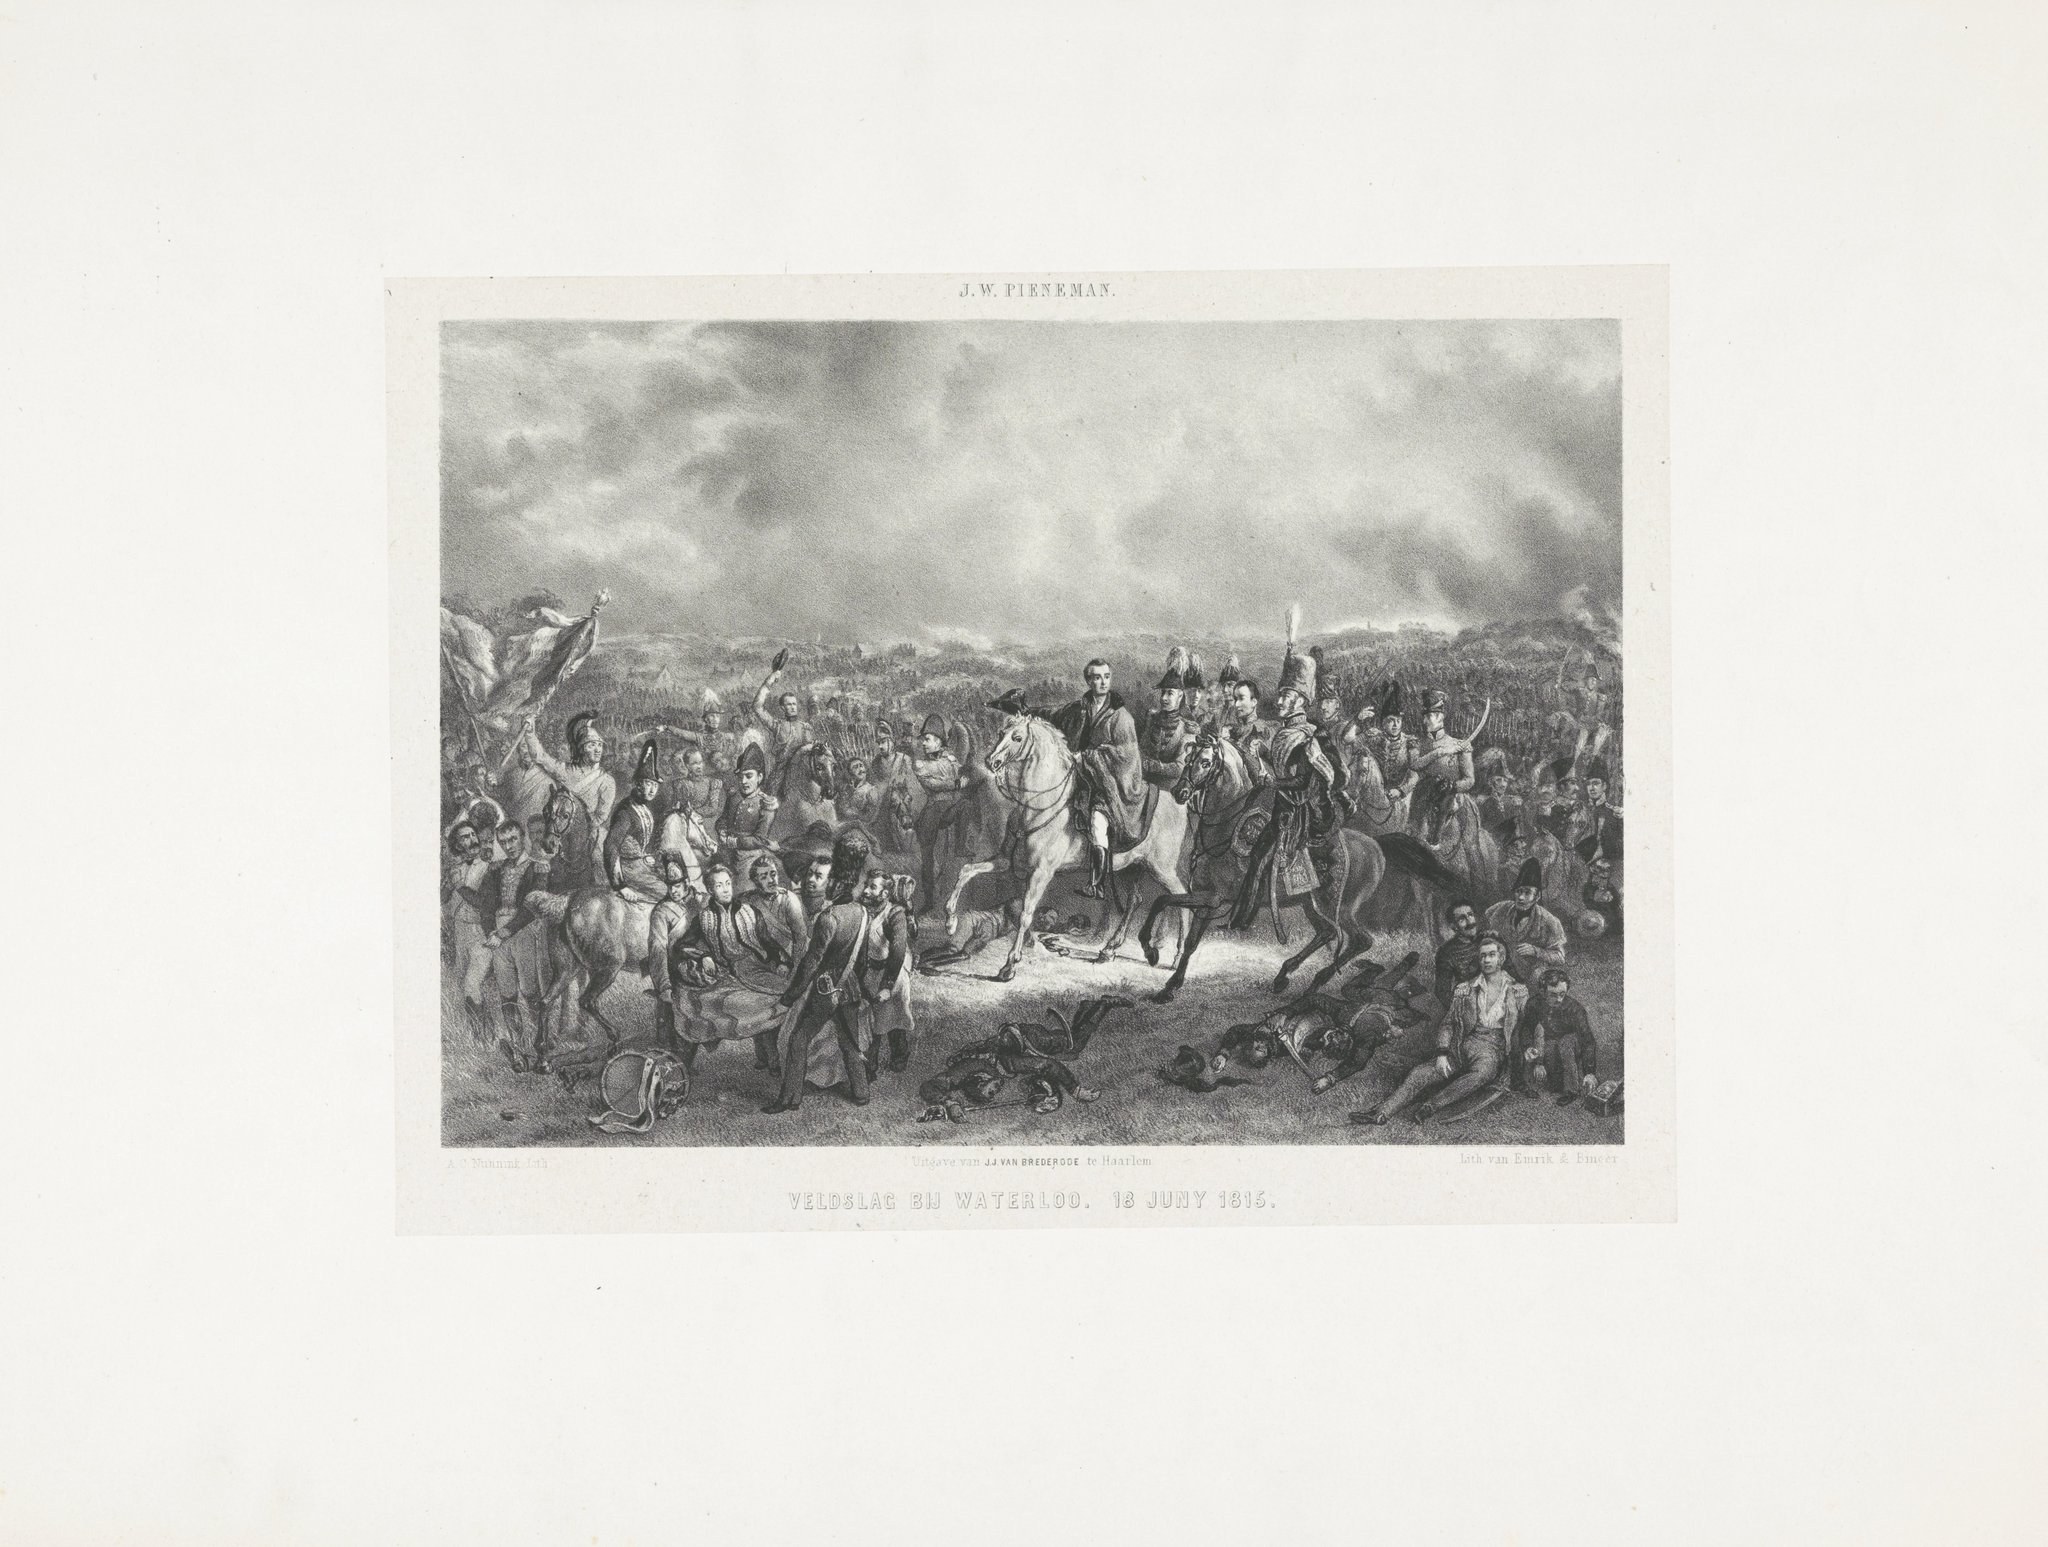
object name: history print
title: Veldslag bij Waterloo. 18 Juny 1815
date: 1824-1850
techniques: printmaking, lithograph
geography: haarlem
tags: the hague, william ii of the netherlands, walmer castle, arthur wellesley of wellington, battle (+ land forces), waterloo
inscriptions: collector's mark: Lugt 2166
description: De slag bij Waterloo, 18 juni 1815. Gezicht op het slagveld op het moment waarop de Engelse bevelhebber Wellington hoort dat Pruisische hulp onderweg is. De gewonde Willem, prins van Oranje, wordt links op de voorgrond weggevoerd. De bevelhebbers en andere officieren te paard staan in het midden, rechts op de voorgrond gewonde en dode soldaten. Op de achtergrond woeden de gevechten op het slagveld. Bij de prent behoort een blad met een handgeschreven vers uit 1824 over Pieneman en het schilderij.